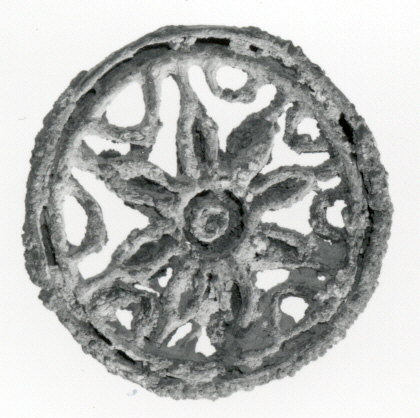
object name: stamp seal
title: Compartmented stamp seal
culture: bactria-margiana archaeological complex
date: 2333-1668 BCE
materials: bronze, copper alloy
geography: bactria-margiana